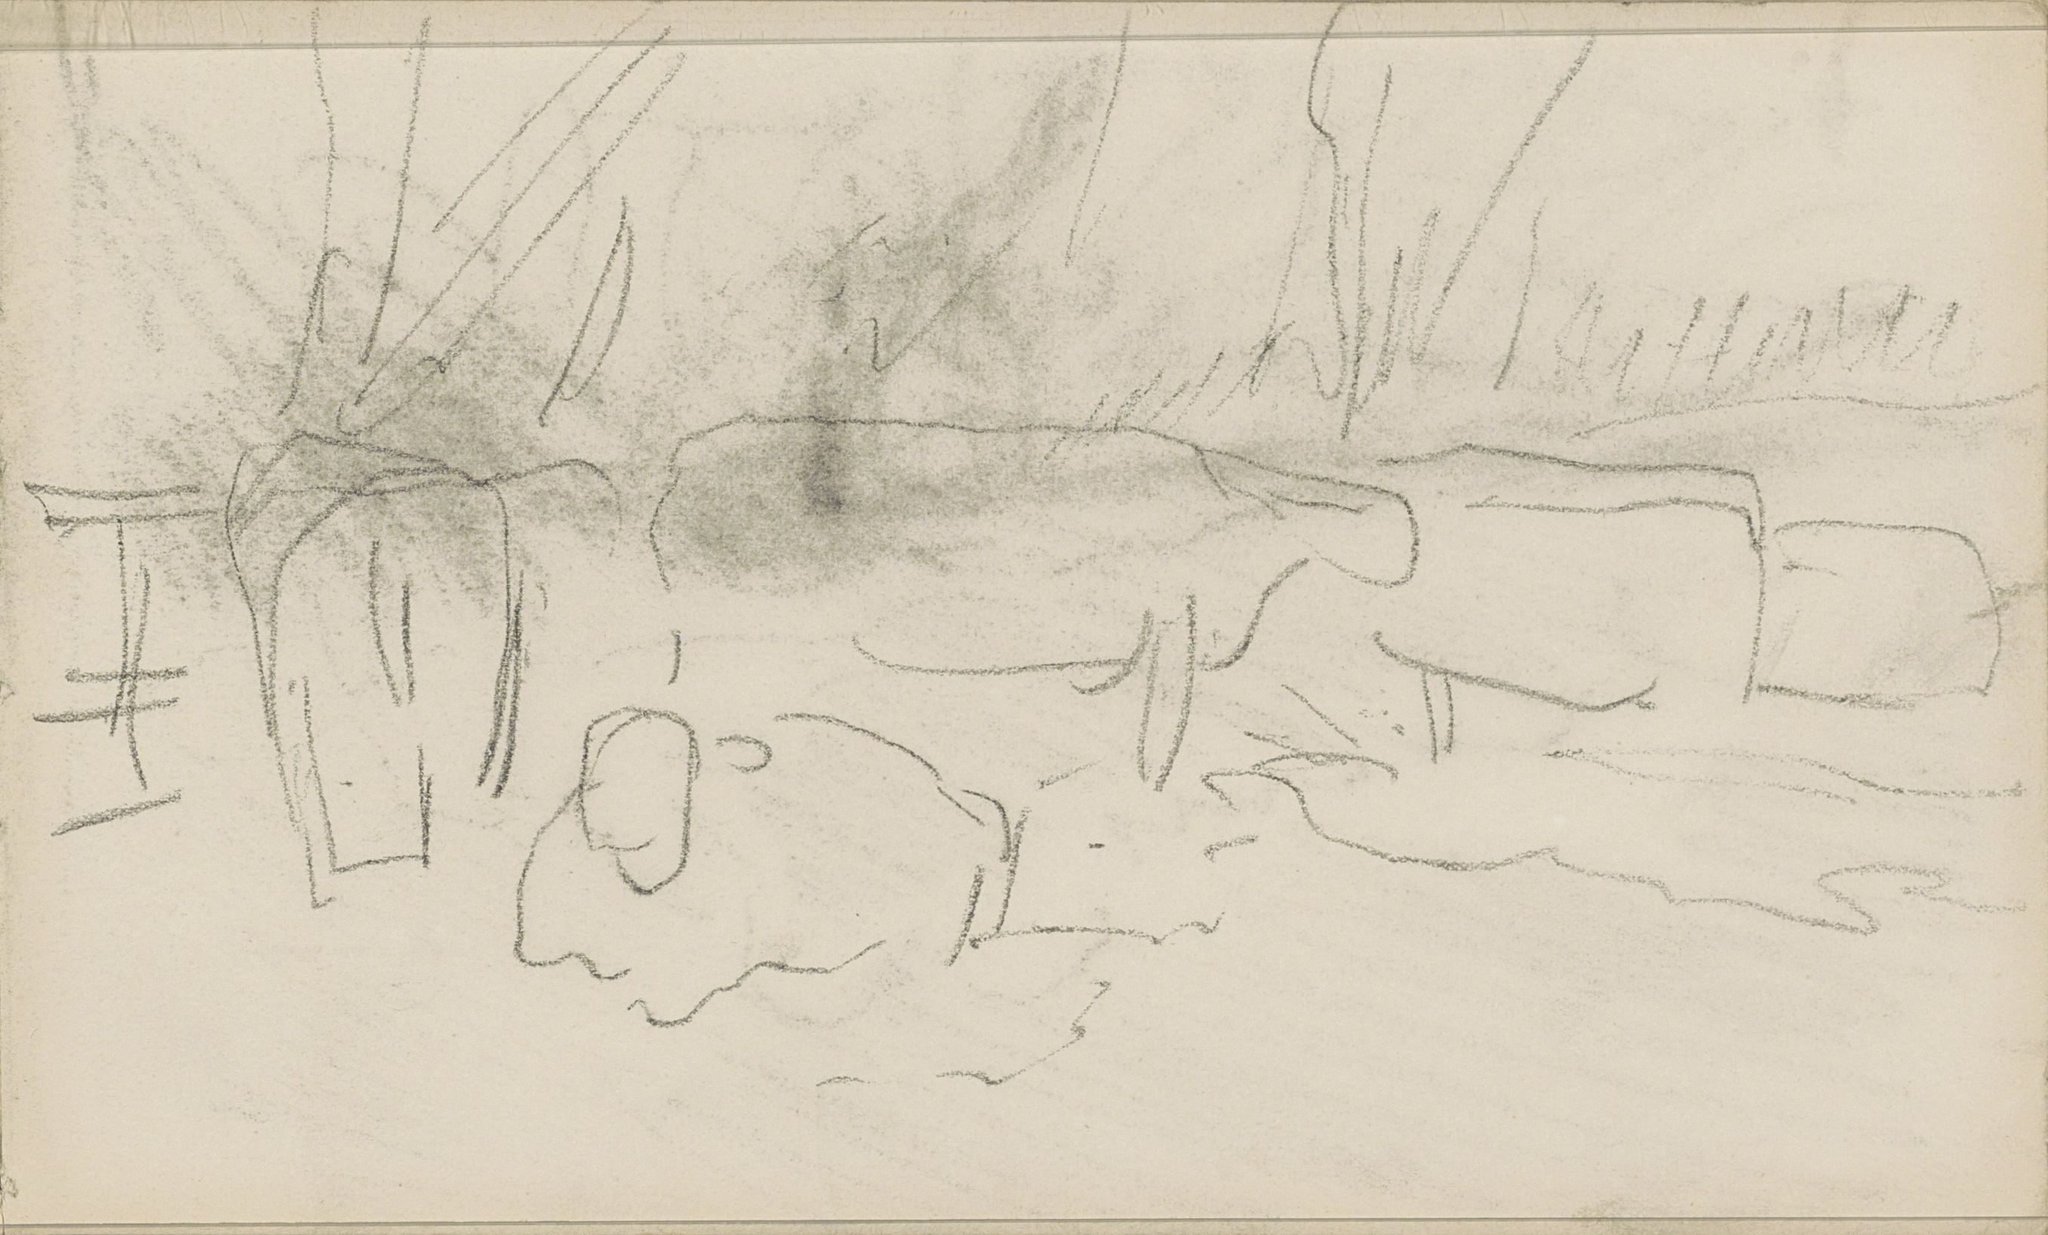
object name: sketchbook leaf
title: Liggende en staande koeien in een landschap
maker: anton mauve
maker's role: draughtsman, painter, print maker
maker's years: 1838-1888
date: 1848-1888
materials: chalk, paper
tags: cow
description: Blad 21 recto uit een schetsboek met 33 bladen.